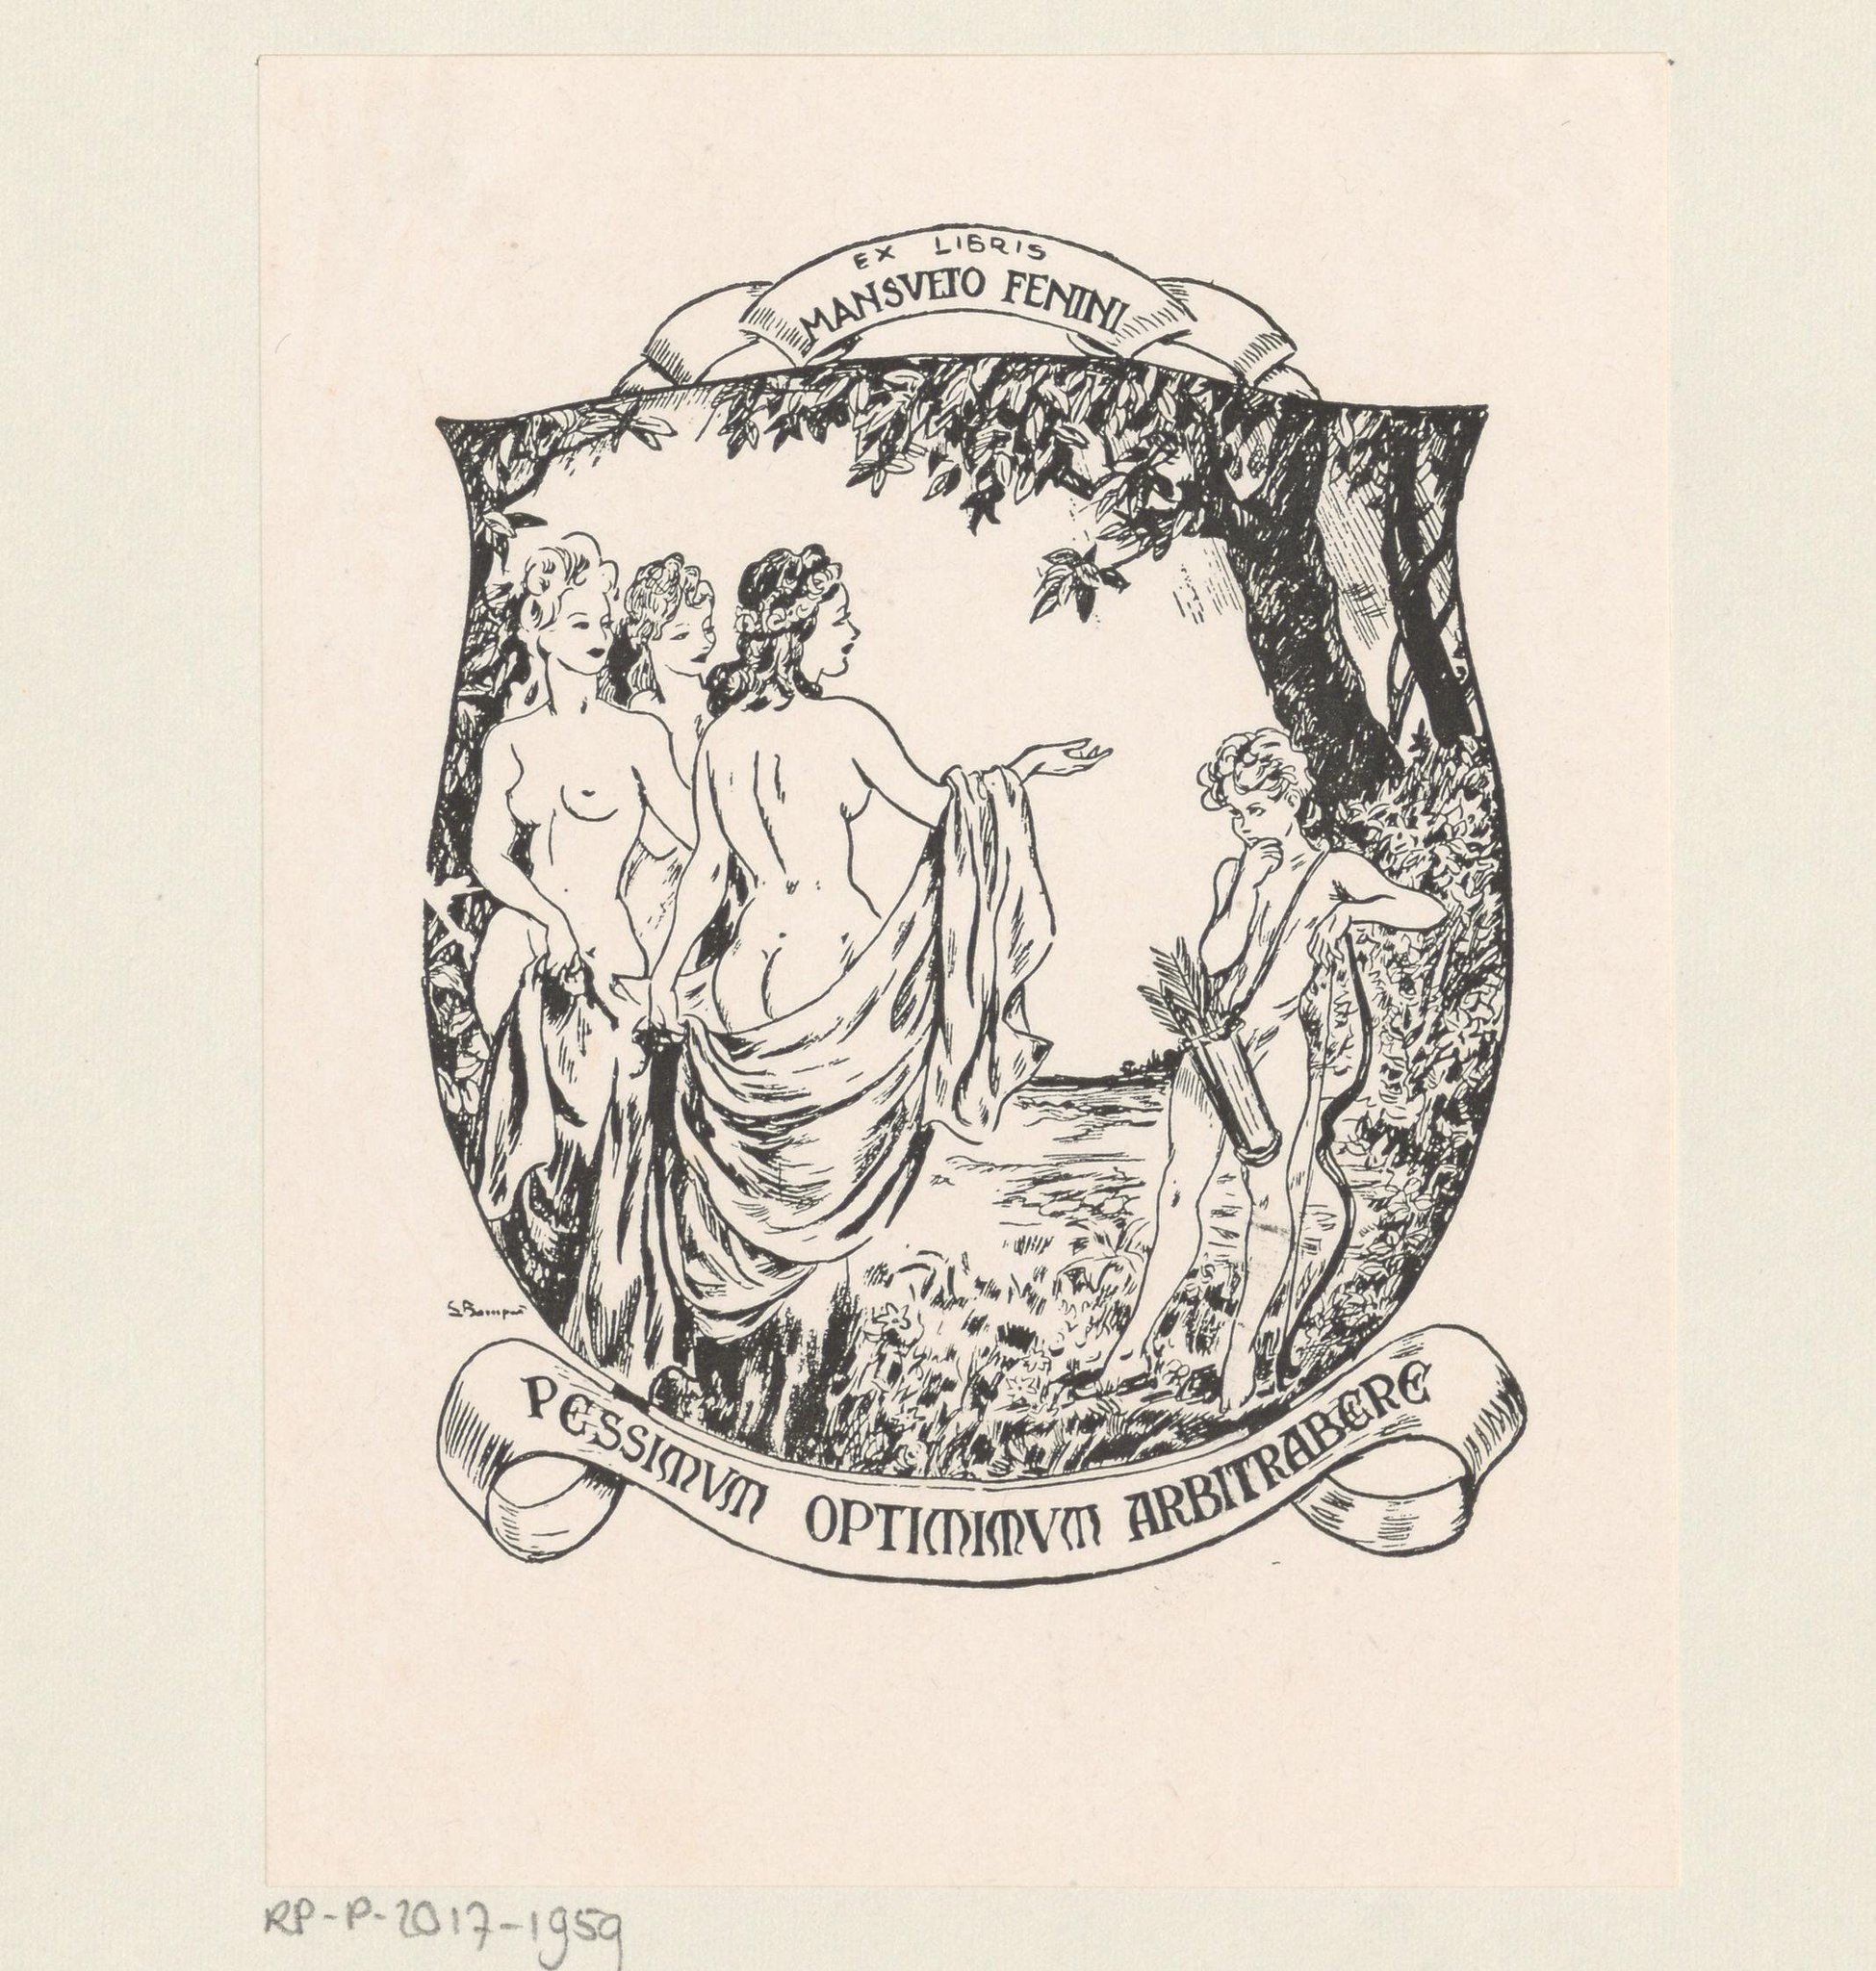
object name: bookplate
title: Ex libris van Mansueto Fenini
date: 1898-1953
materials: paper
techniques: printing block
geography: italy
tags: artist, trees, woman (showing herself) undressed, quasi-nude, graces (charites), generally three in number; 'gratie' (ripa), (story of) cupid, amor (eros), archer's weapons